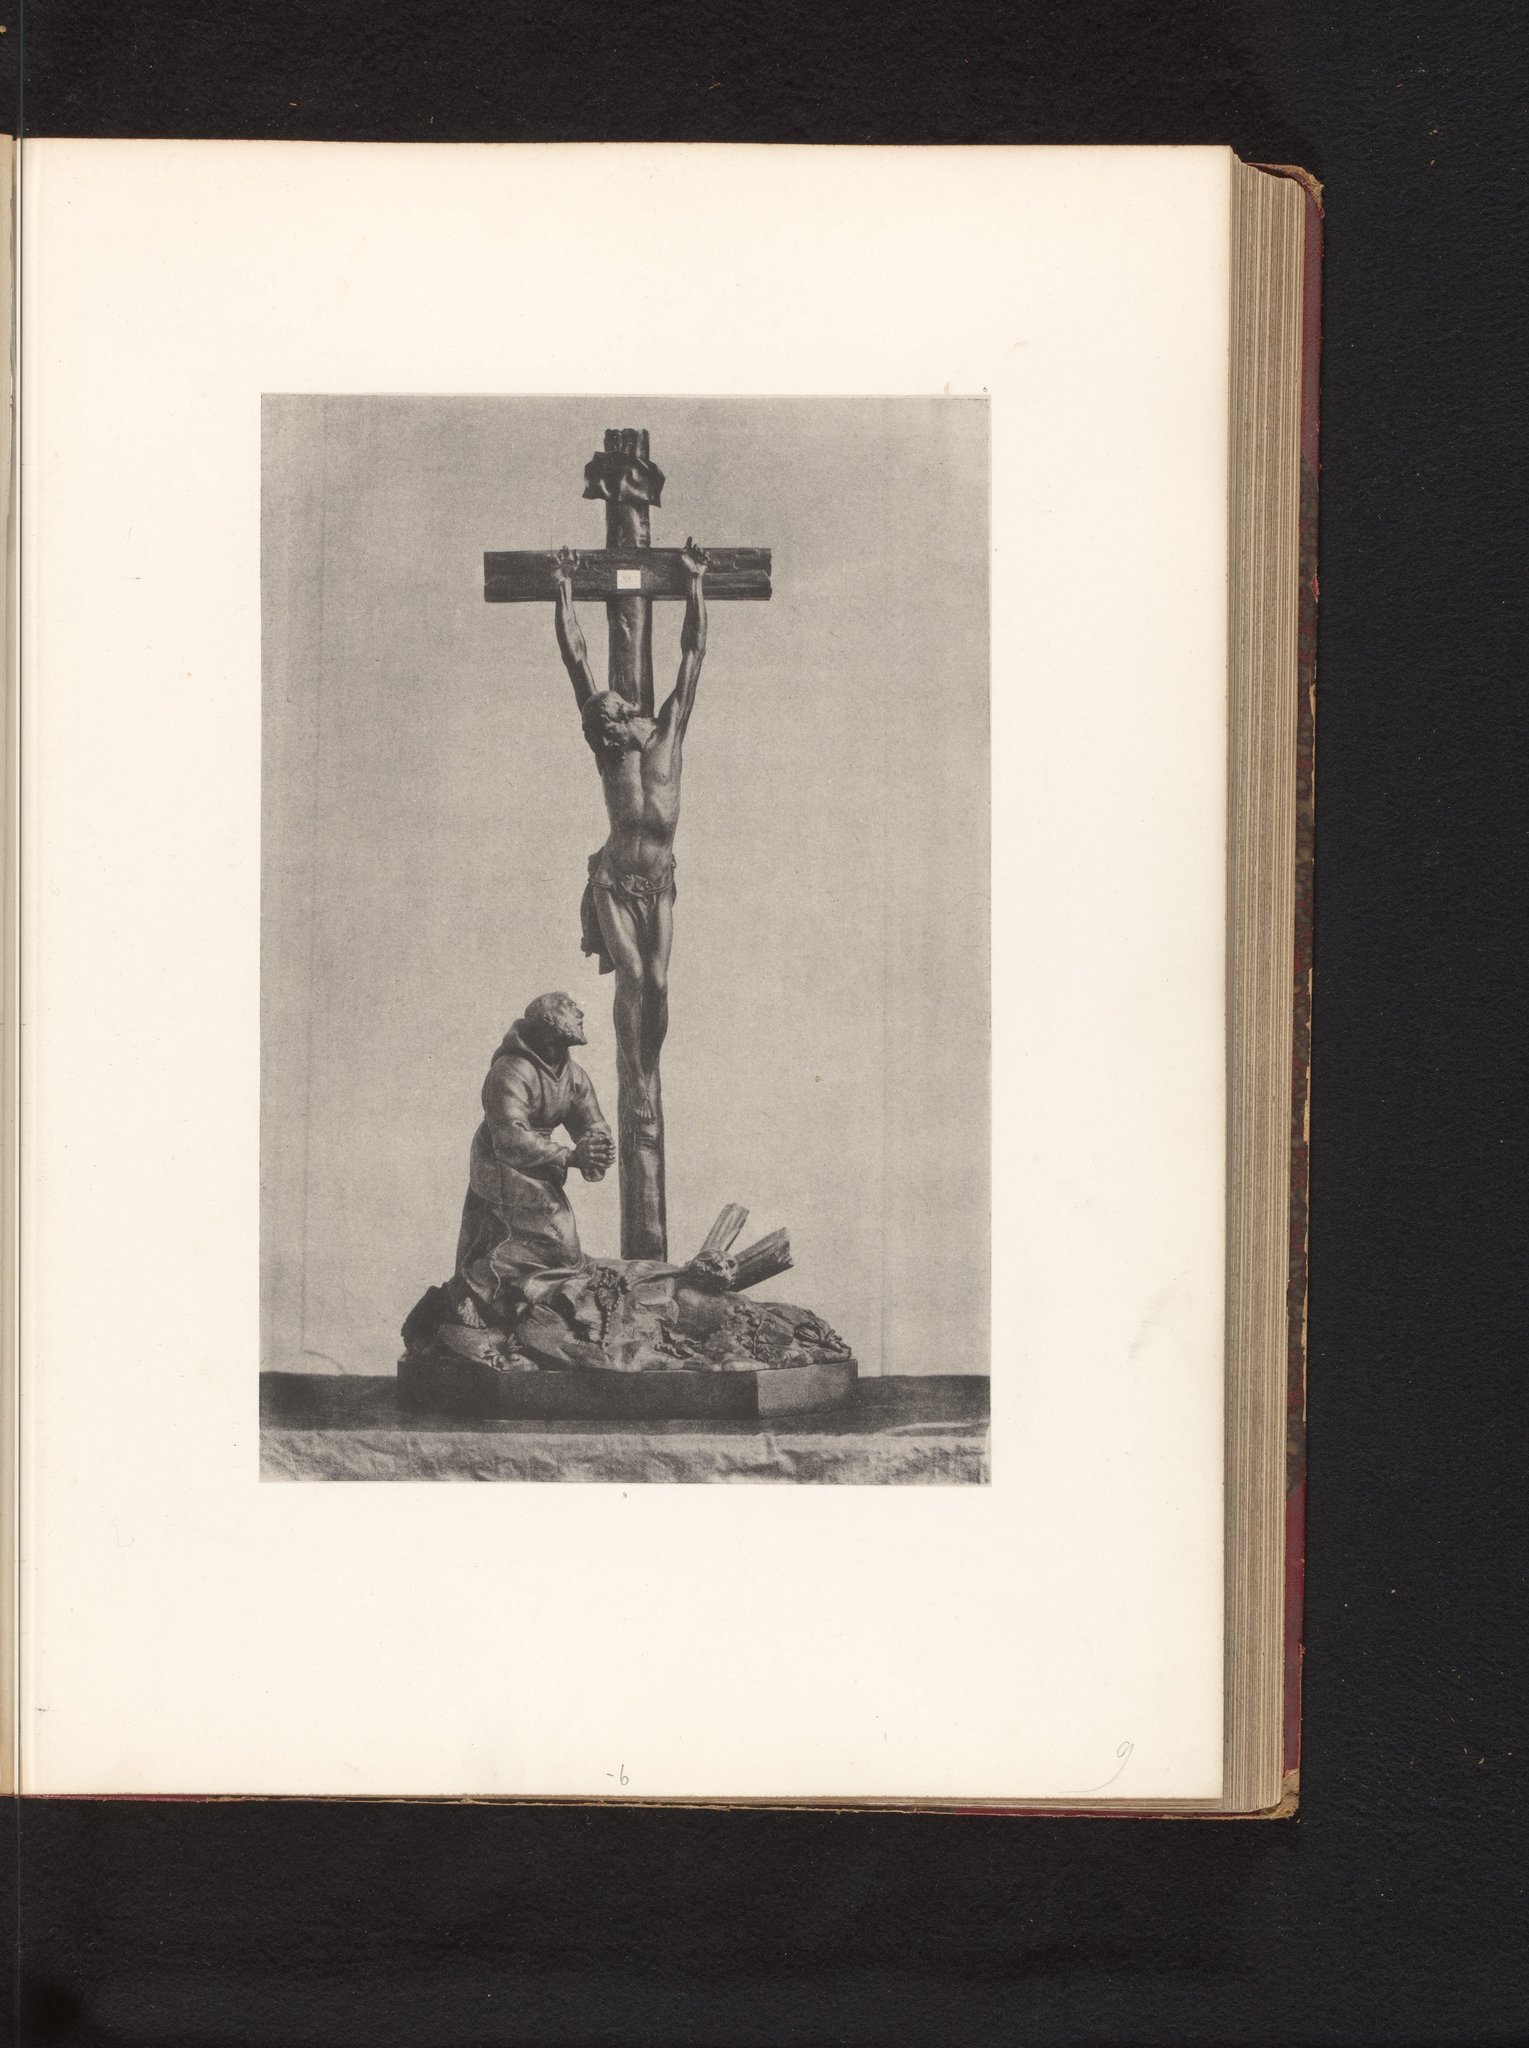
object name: photomechanical print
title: Crucifix van palmhout uit de collectie van C.J. Vervloet in Brussel, opgesteld op een tentoonstelling over religieuze objecten uit de middeleeuwen en renaissance in 1864 in Mechelen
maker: joseph maes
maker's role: fotograaf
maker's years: 1838-1908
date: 1864-1866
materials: paper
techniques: photolithography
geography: mechelen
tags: altarcross, crucifix, piece of sculpture, reproduction of a piece of sculpture (+ bone, ivory ~ arts), mechelen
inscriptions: number: ‘9’, number: ‘9’, number: ‘-6’